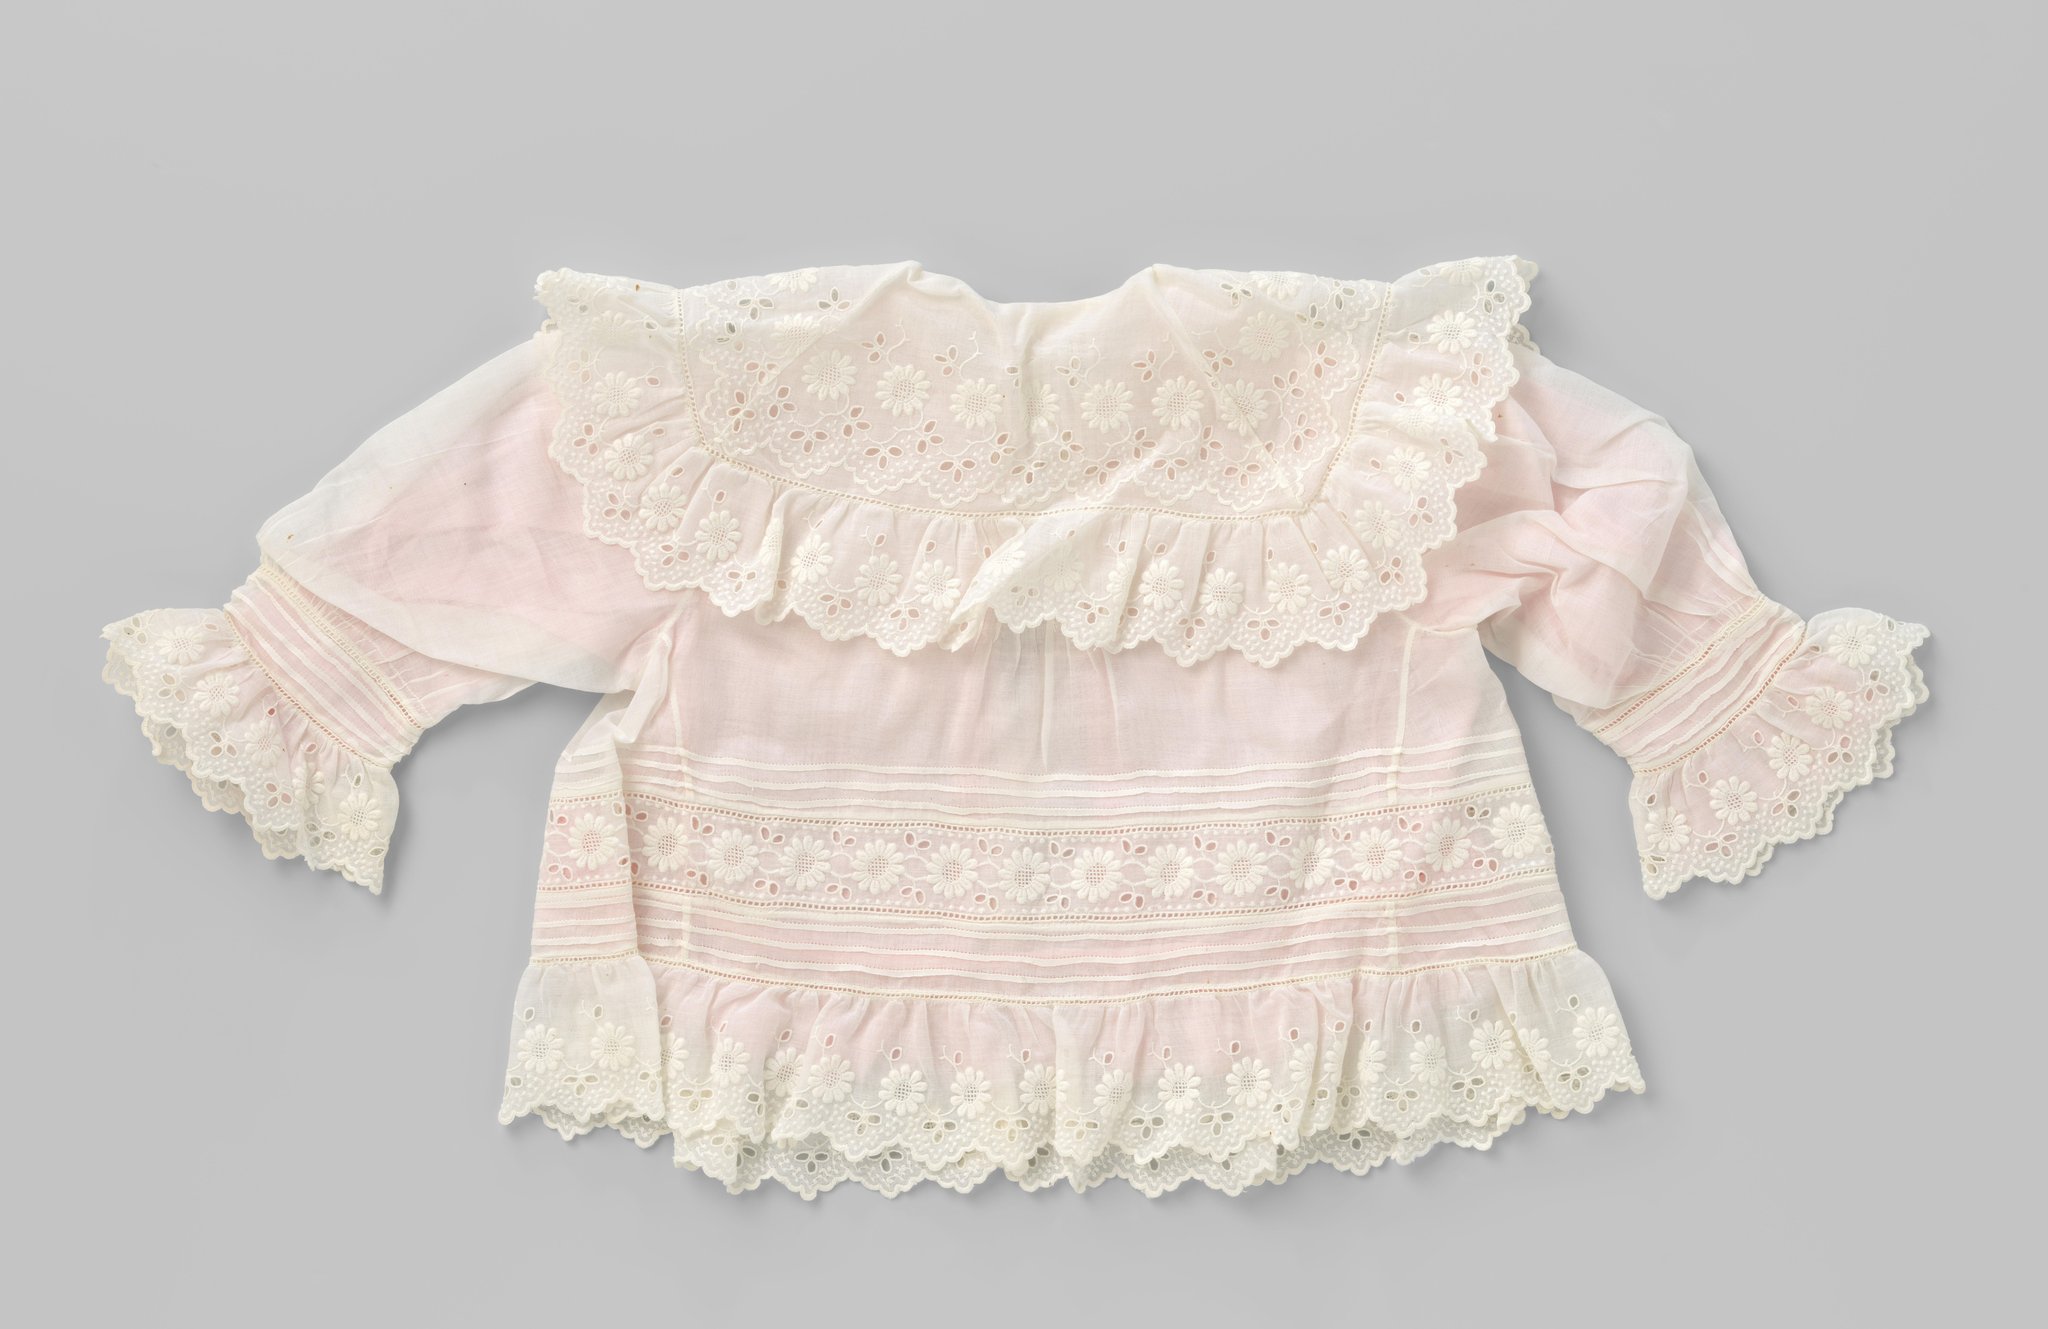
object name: childrenswear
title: Wit vest met witwerk en roze voering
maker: Anonymous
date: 1900-1950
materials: textile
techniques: embroidery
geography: europe